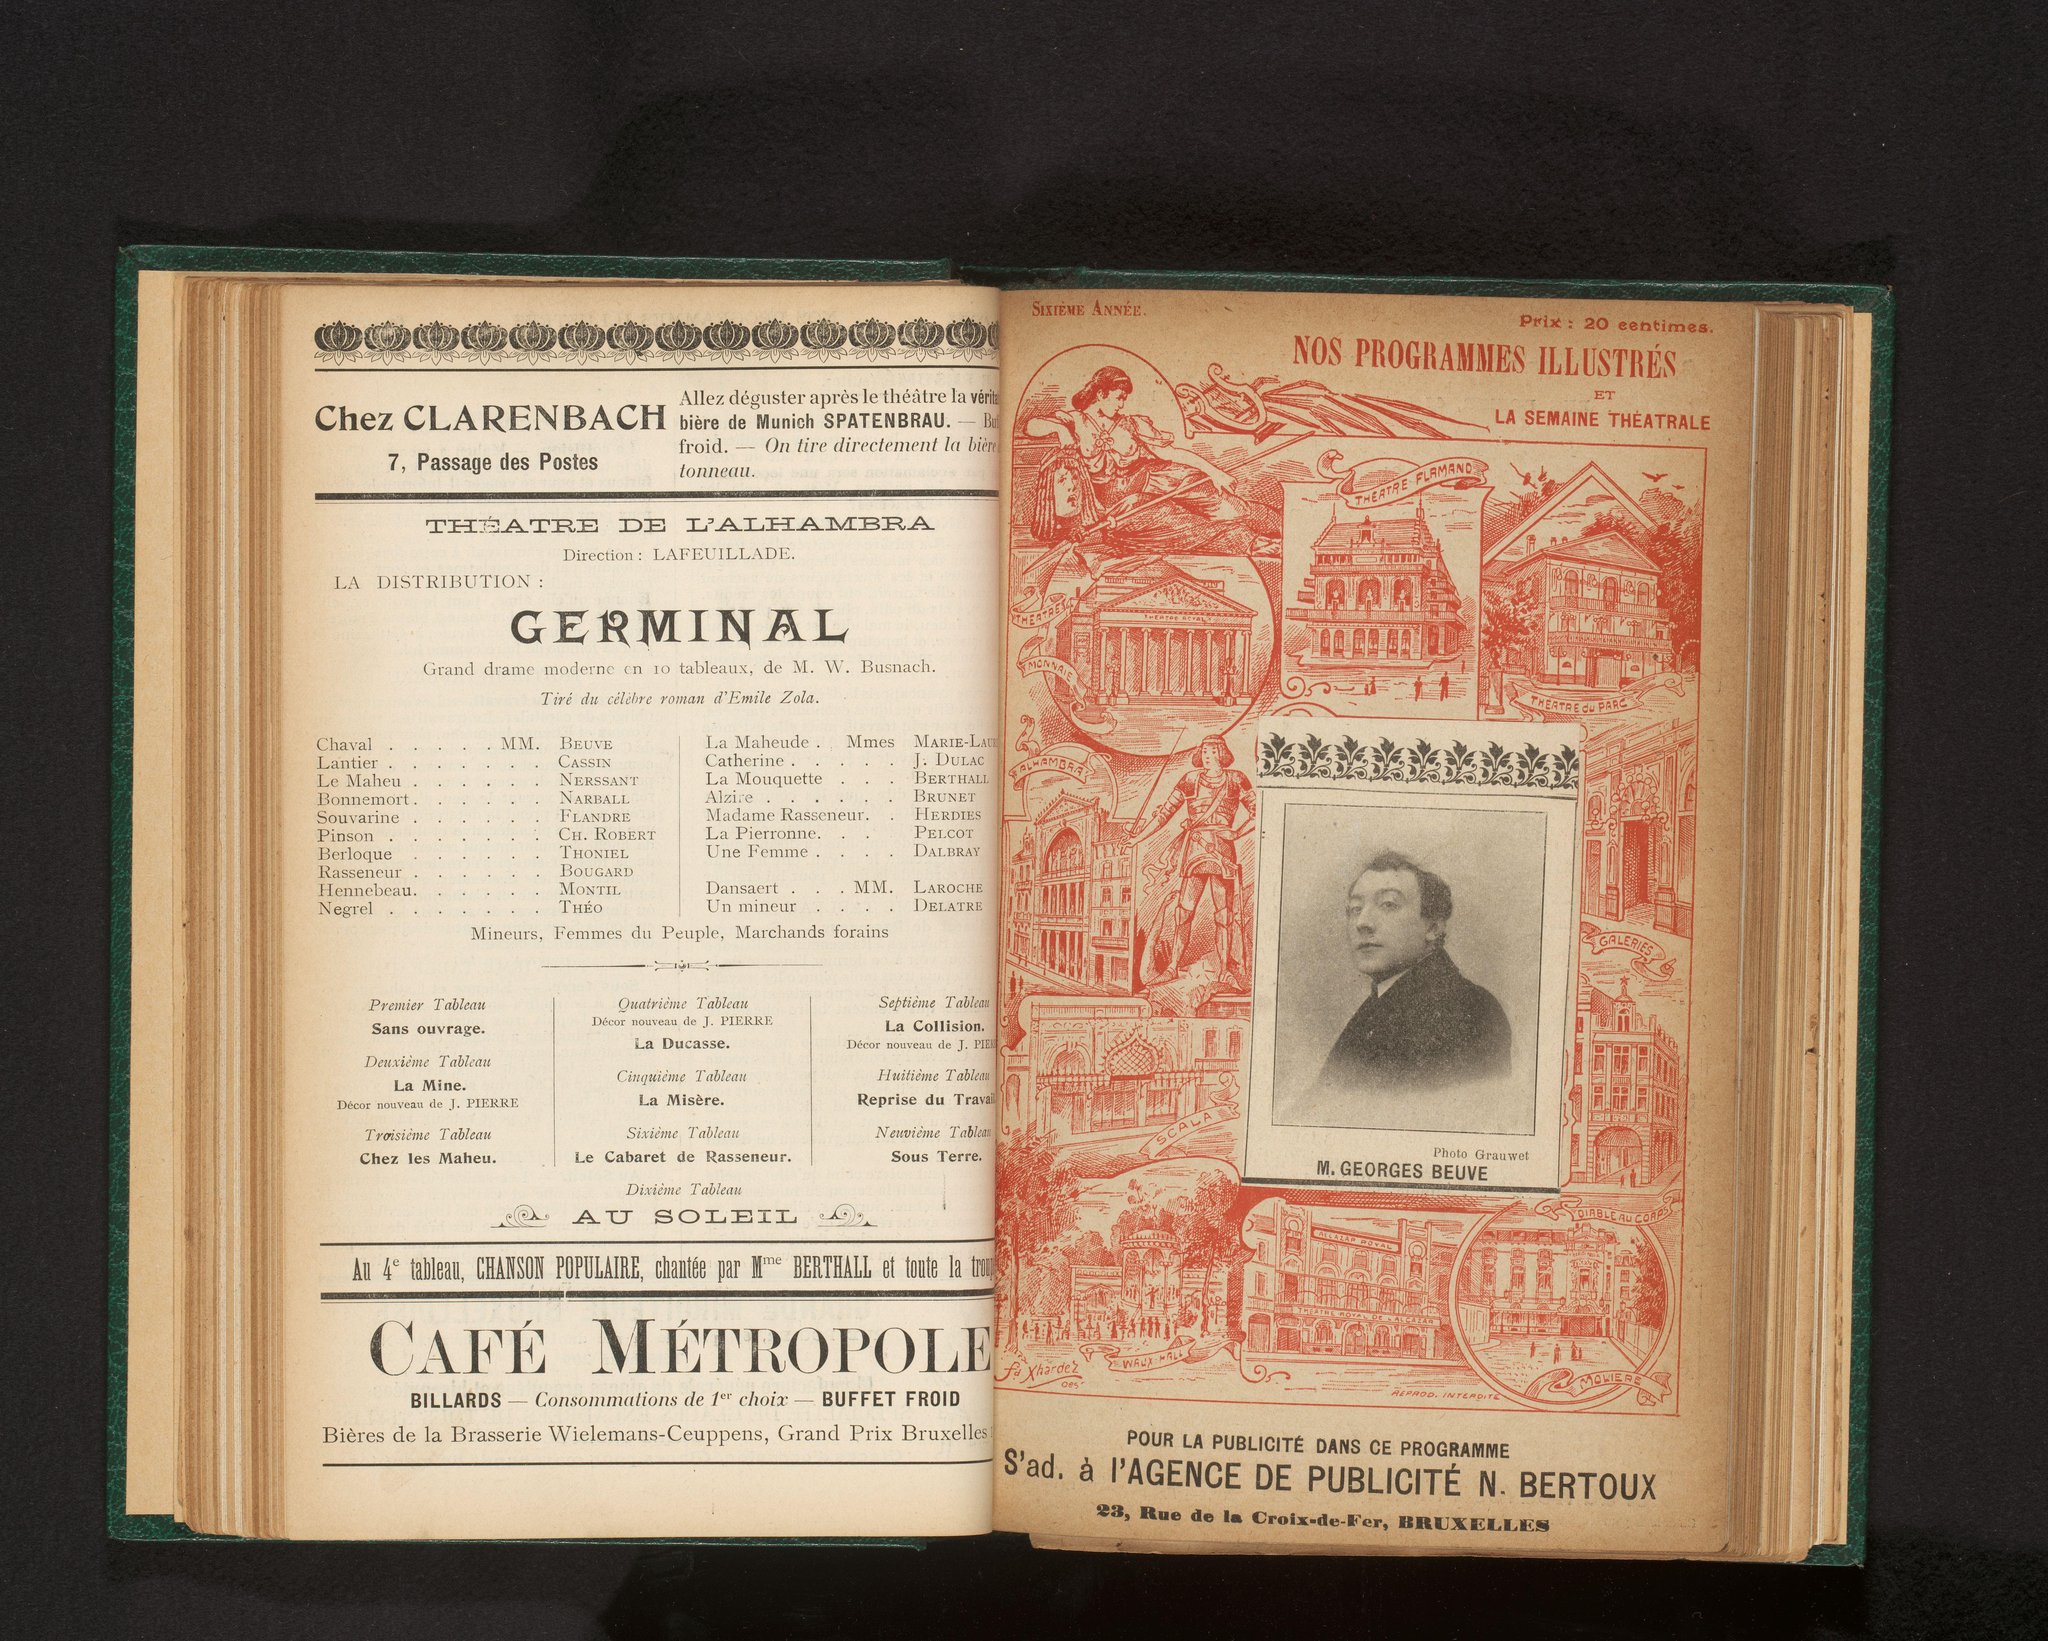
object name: photomechanical print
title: M. Georges Beuve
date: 1895-1900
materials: paper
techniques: autotype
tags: adult man, historical persons